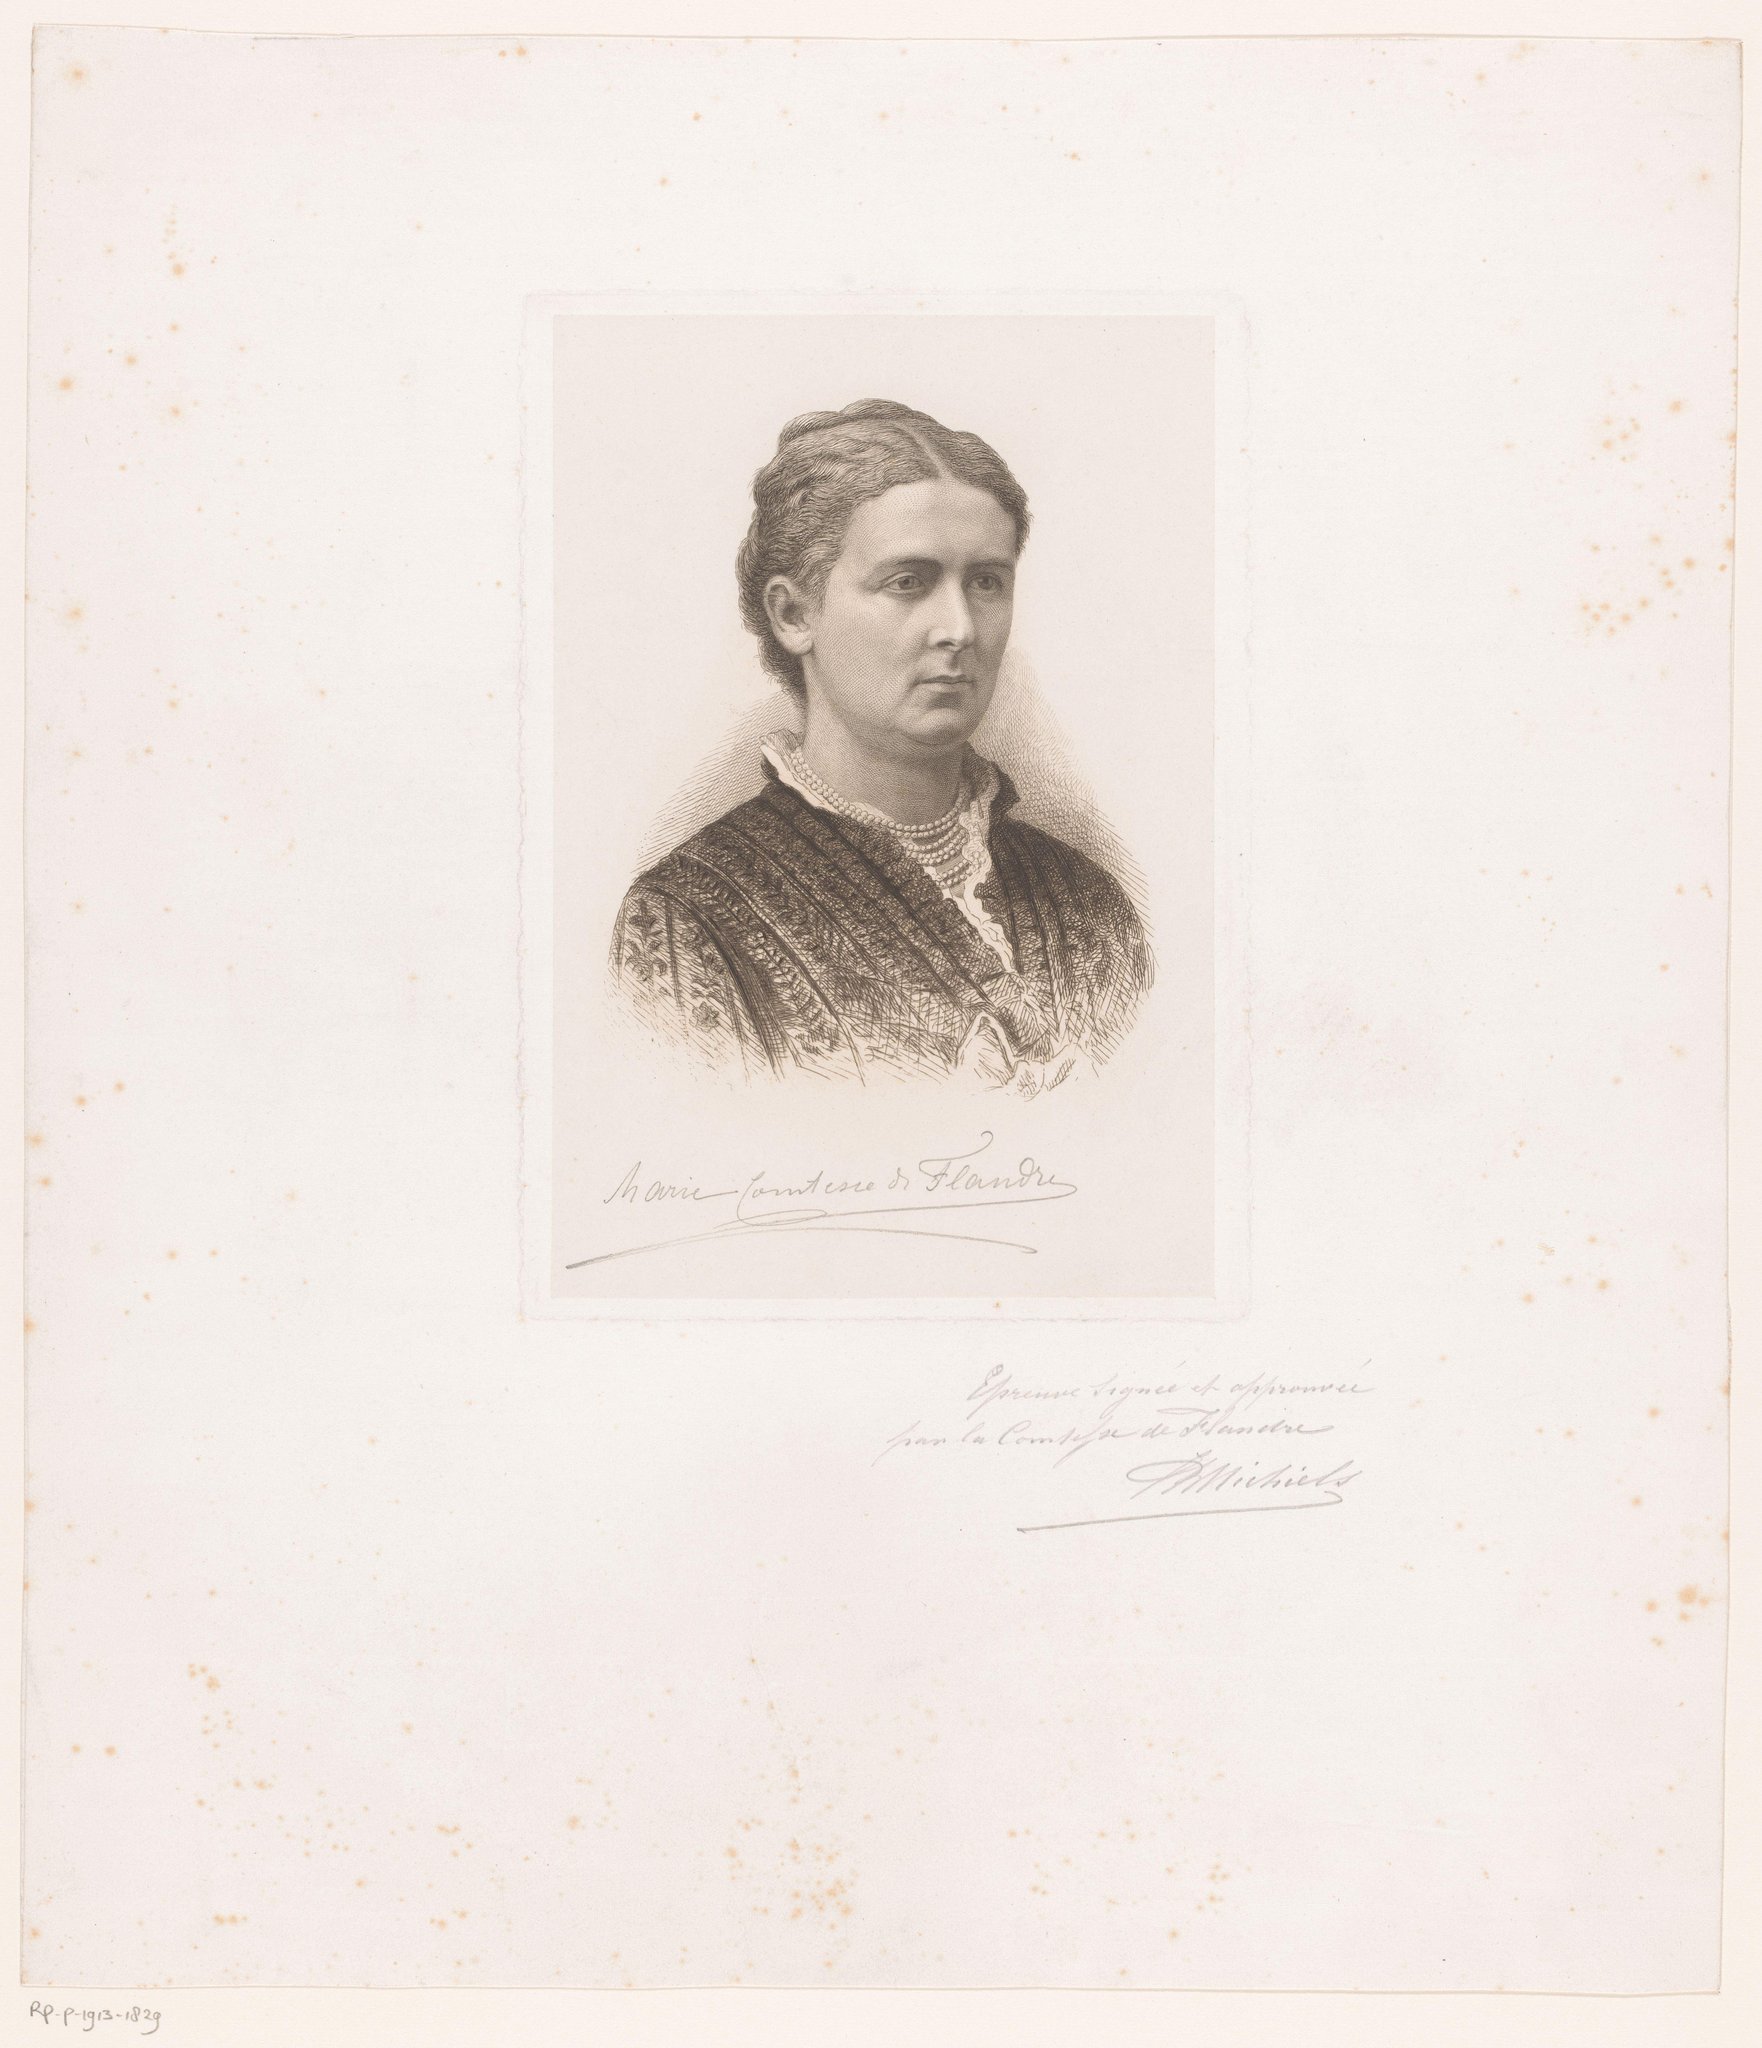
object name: print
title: Portret van Maria von Hohenzollern-Sigmaringen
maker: jean baptiste pierre michiels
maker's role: print maker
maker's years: 1821-1890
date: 1882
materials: paper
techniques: etching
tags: brussels, print maker, maria van hohenzollern-sigmaringen (gravin van vlaanderen), adult woman, historical persons, pearl; pearl necklace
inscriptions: collector's mark: Lugt 2228, inscription: ‘Epreuve signée et approuvée par la Comtesse de Flandre’